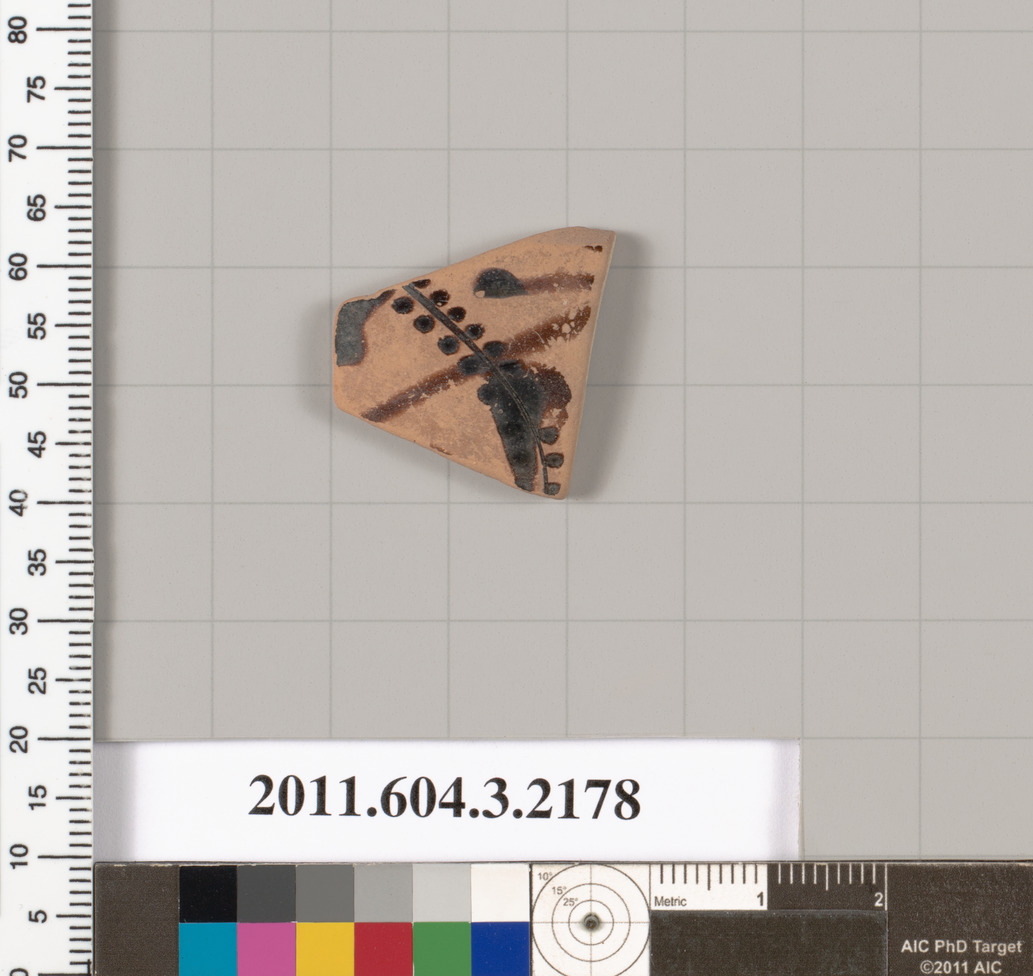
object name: kylix fragment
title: Terracotta fragment of a kylix (drinking cup)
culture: greek, attic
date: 525-501 BCE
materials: terracotta